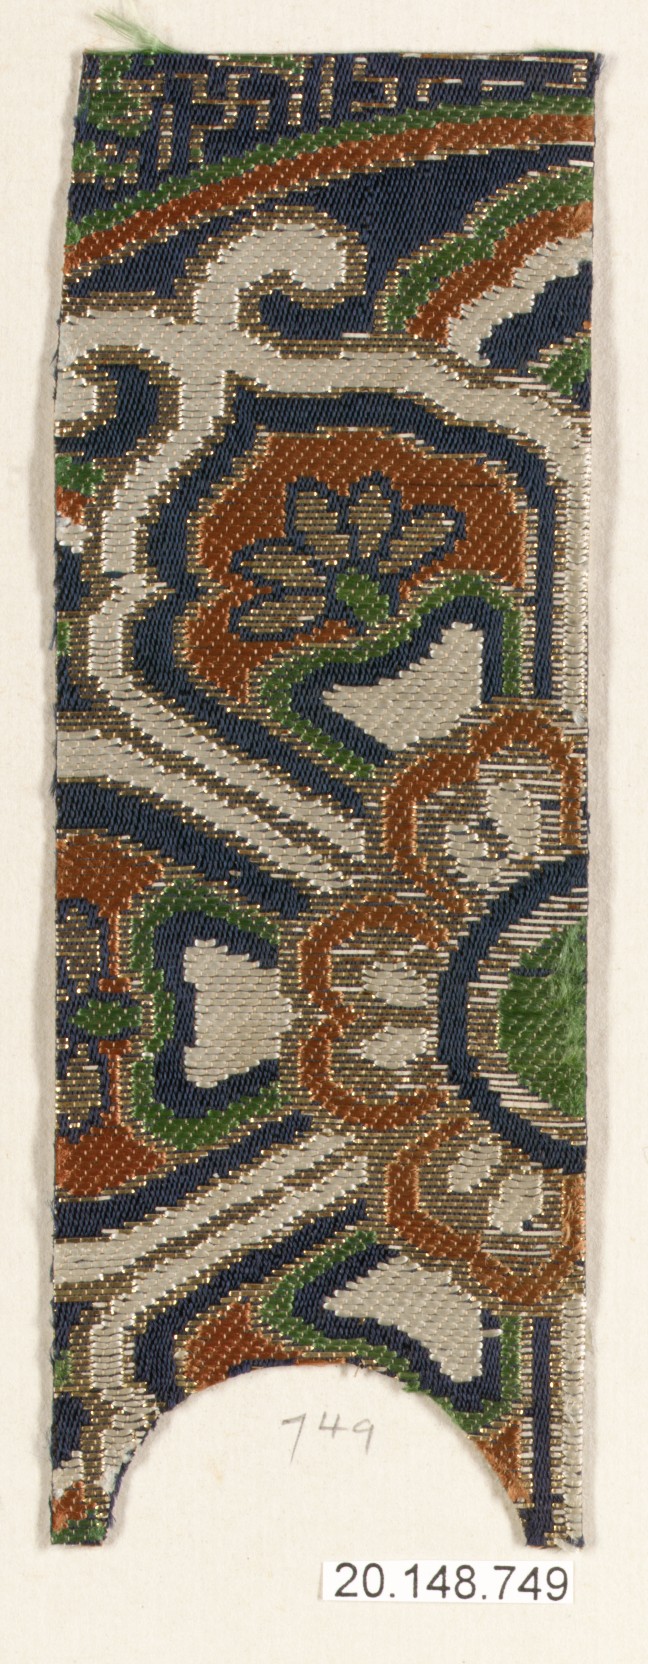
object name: piece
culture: chinese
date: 1601-1700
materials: silk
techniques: compound weave